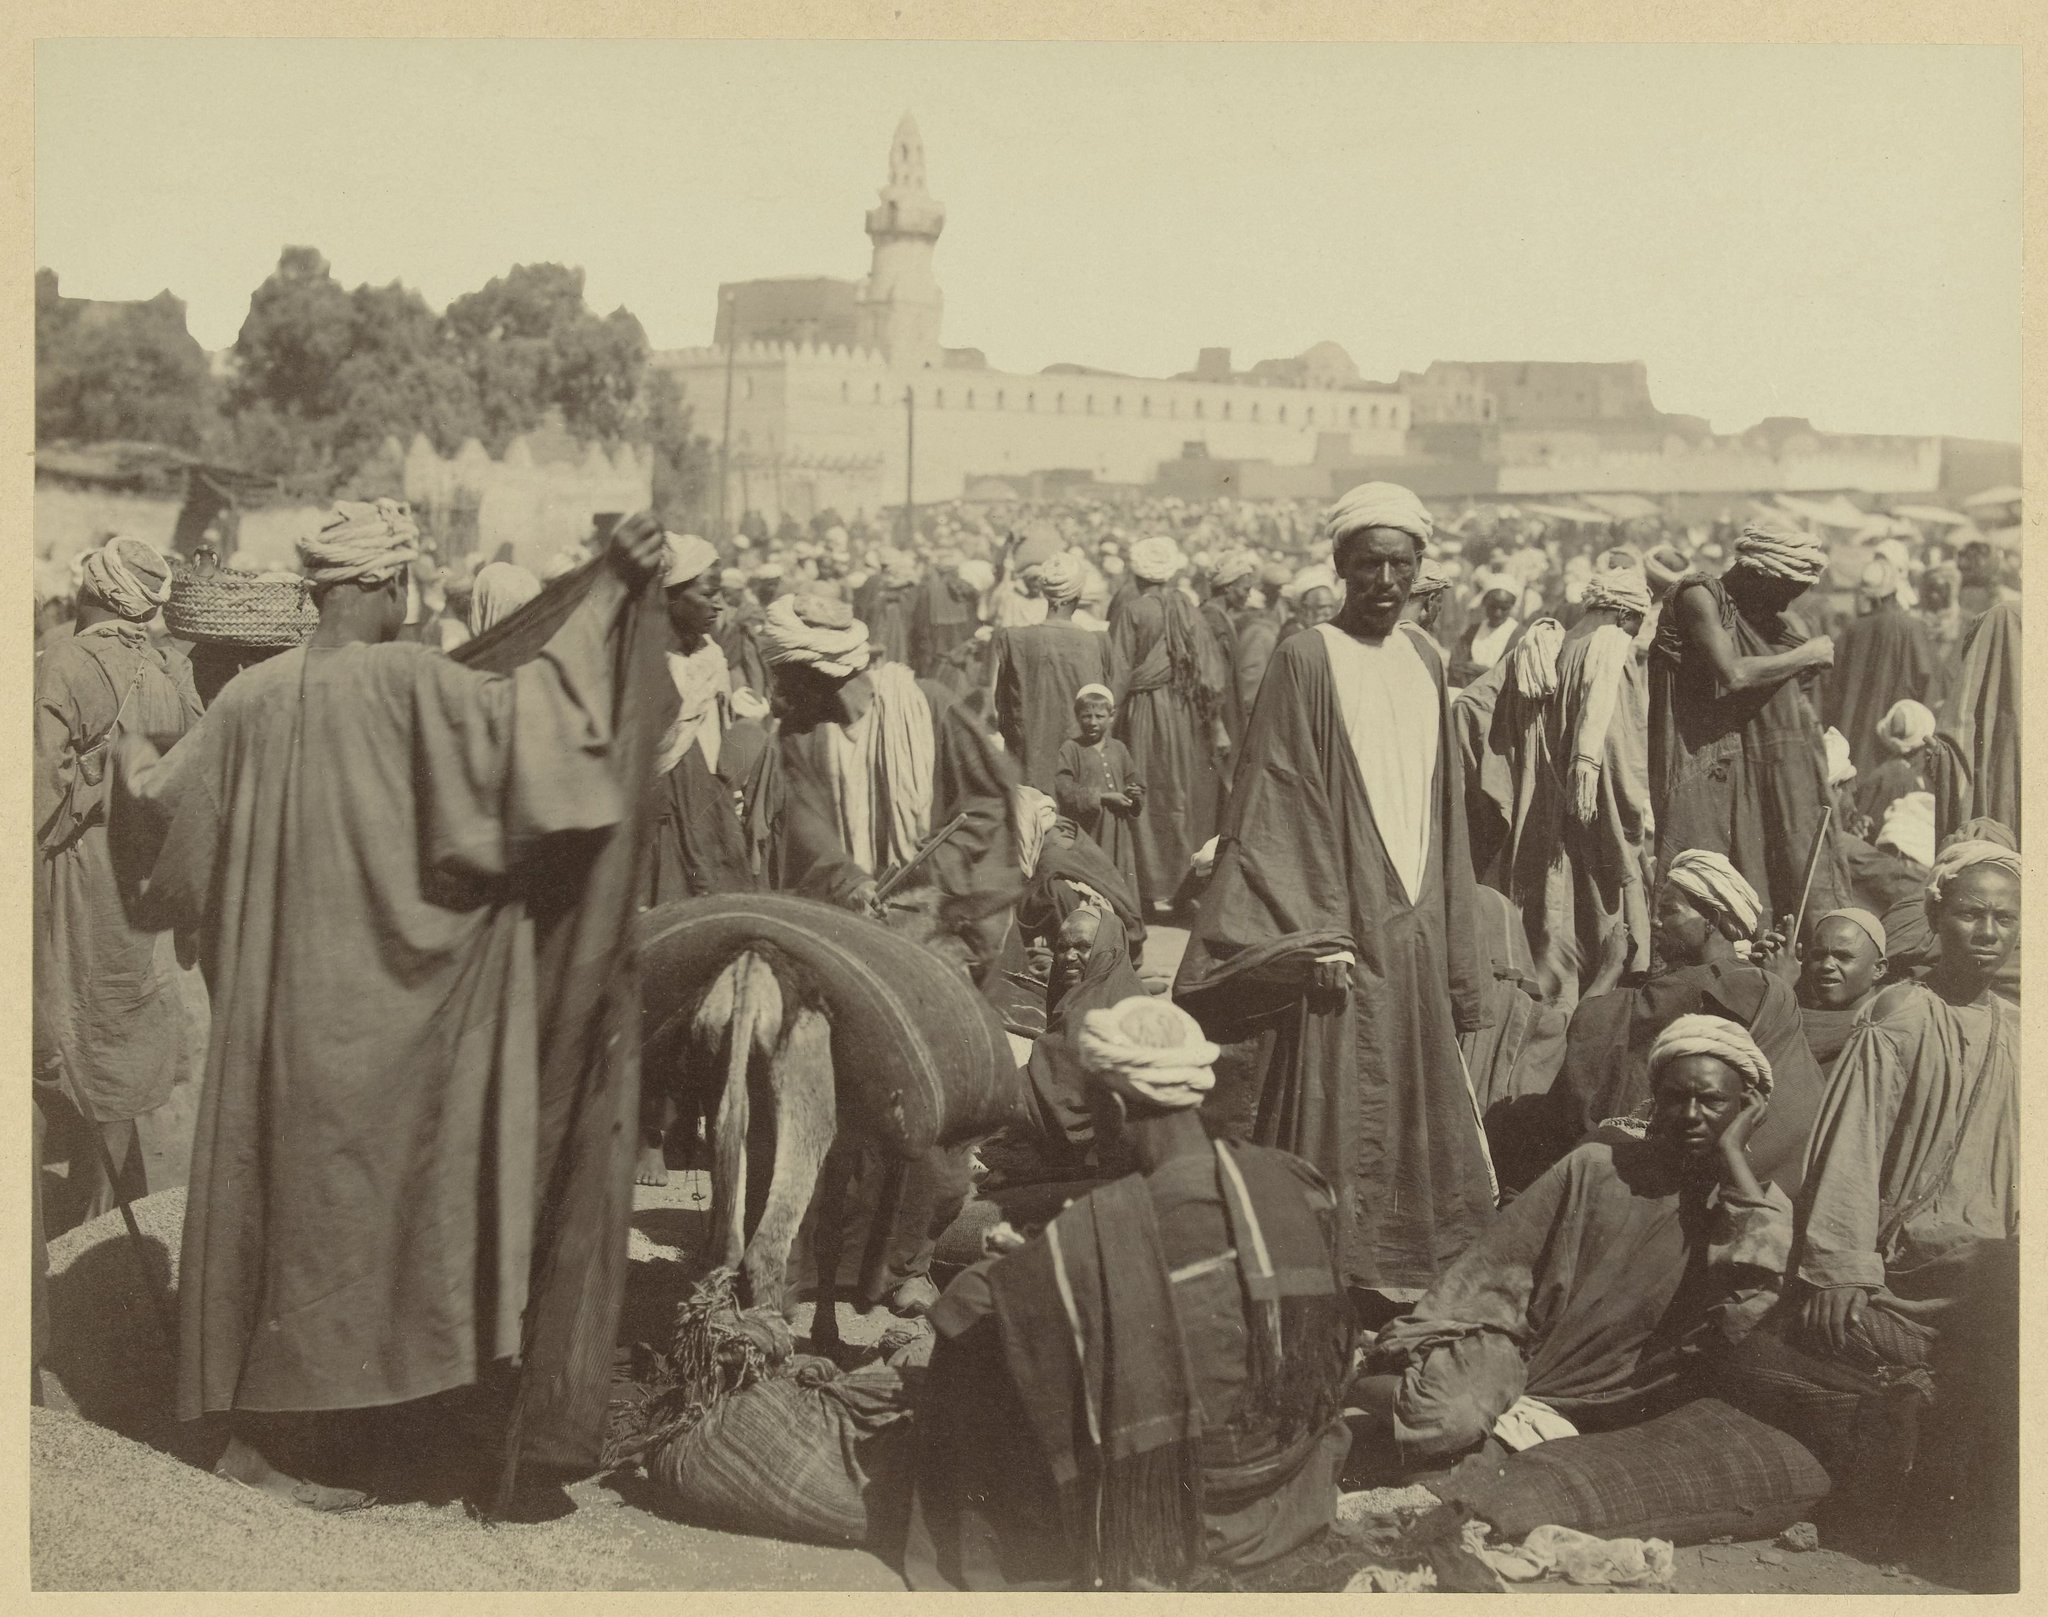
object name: photograph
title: E 61. Markt te Asyût. Opper-Egypte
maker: Anonymous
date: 1890-1895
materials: cardboard, paper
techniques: albumen print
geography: assioet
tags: market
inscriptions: stamp: ‘Gemeentelijke bibliotheek/ Rotterdam’, check stamp: ‘Bristol/ L.M.’, title: ‘E 61. Markt te Asyût. Opper-Egypte.’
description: Onderdeel van een groep door fotograaf Richard Polak op reis verzamelde foto’s. Deze foto is samen met andere op zijn reizen verzamelde foto's tentoongesteld bij de Rotterdamsche Kunstkring (1895), Arti en Amicitiae te Amsterdam (1897-1898?) en Societeit 't Collegie te Kampen (datum vooralsnog onbekend).